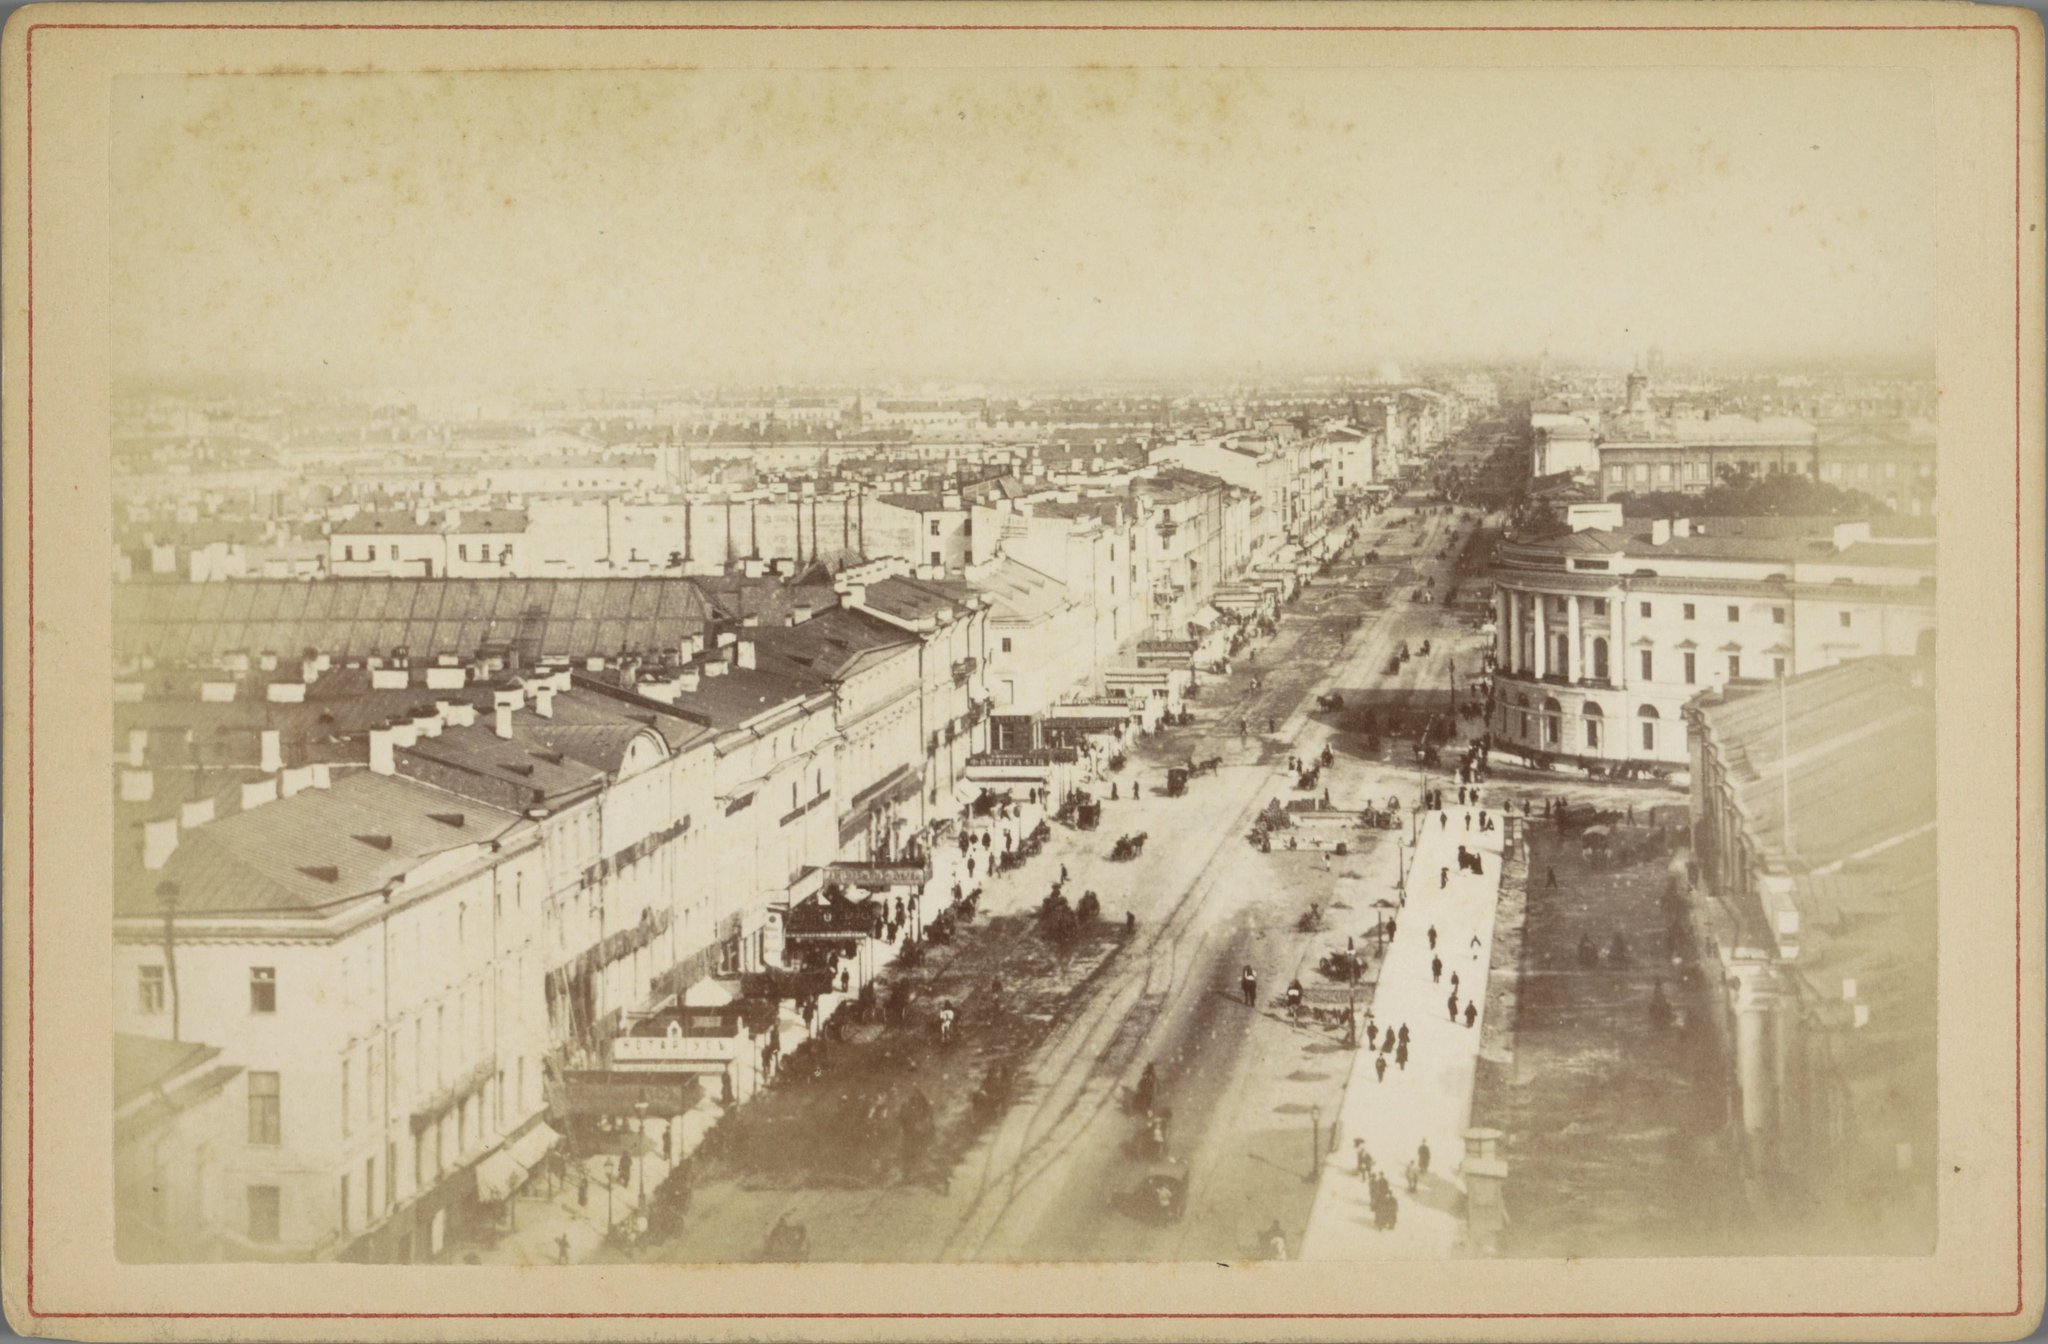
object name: photograph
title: Gezicht op Nevsky Prospekt in Sint-Petersburg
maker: joseph daziaro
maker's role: publisher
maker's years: 1831-1892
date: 1880-1900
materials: cardboard, photographic support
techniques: albumen print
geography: sint-petersburg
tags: street (+ city(-scape) with figures, staffage)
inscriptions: inscription: ‘Rue de Newsky’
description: Onderdeel van Fotoalbum met opnames van Sint-Petersburg.